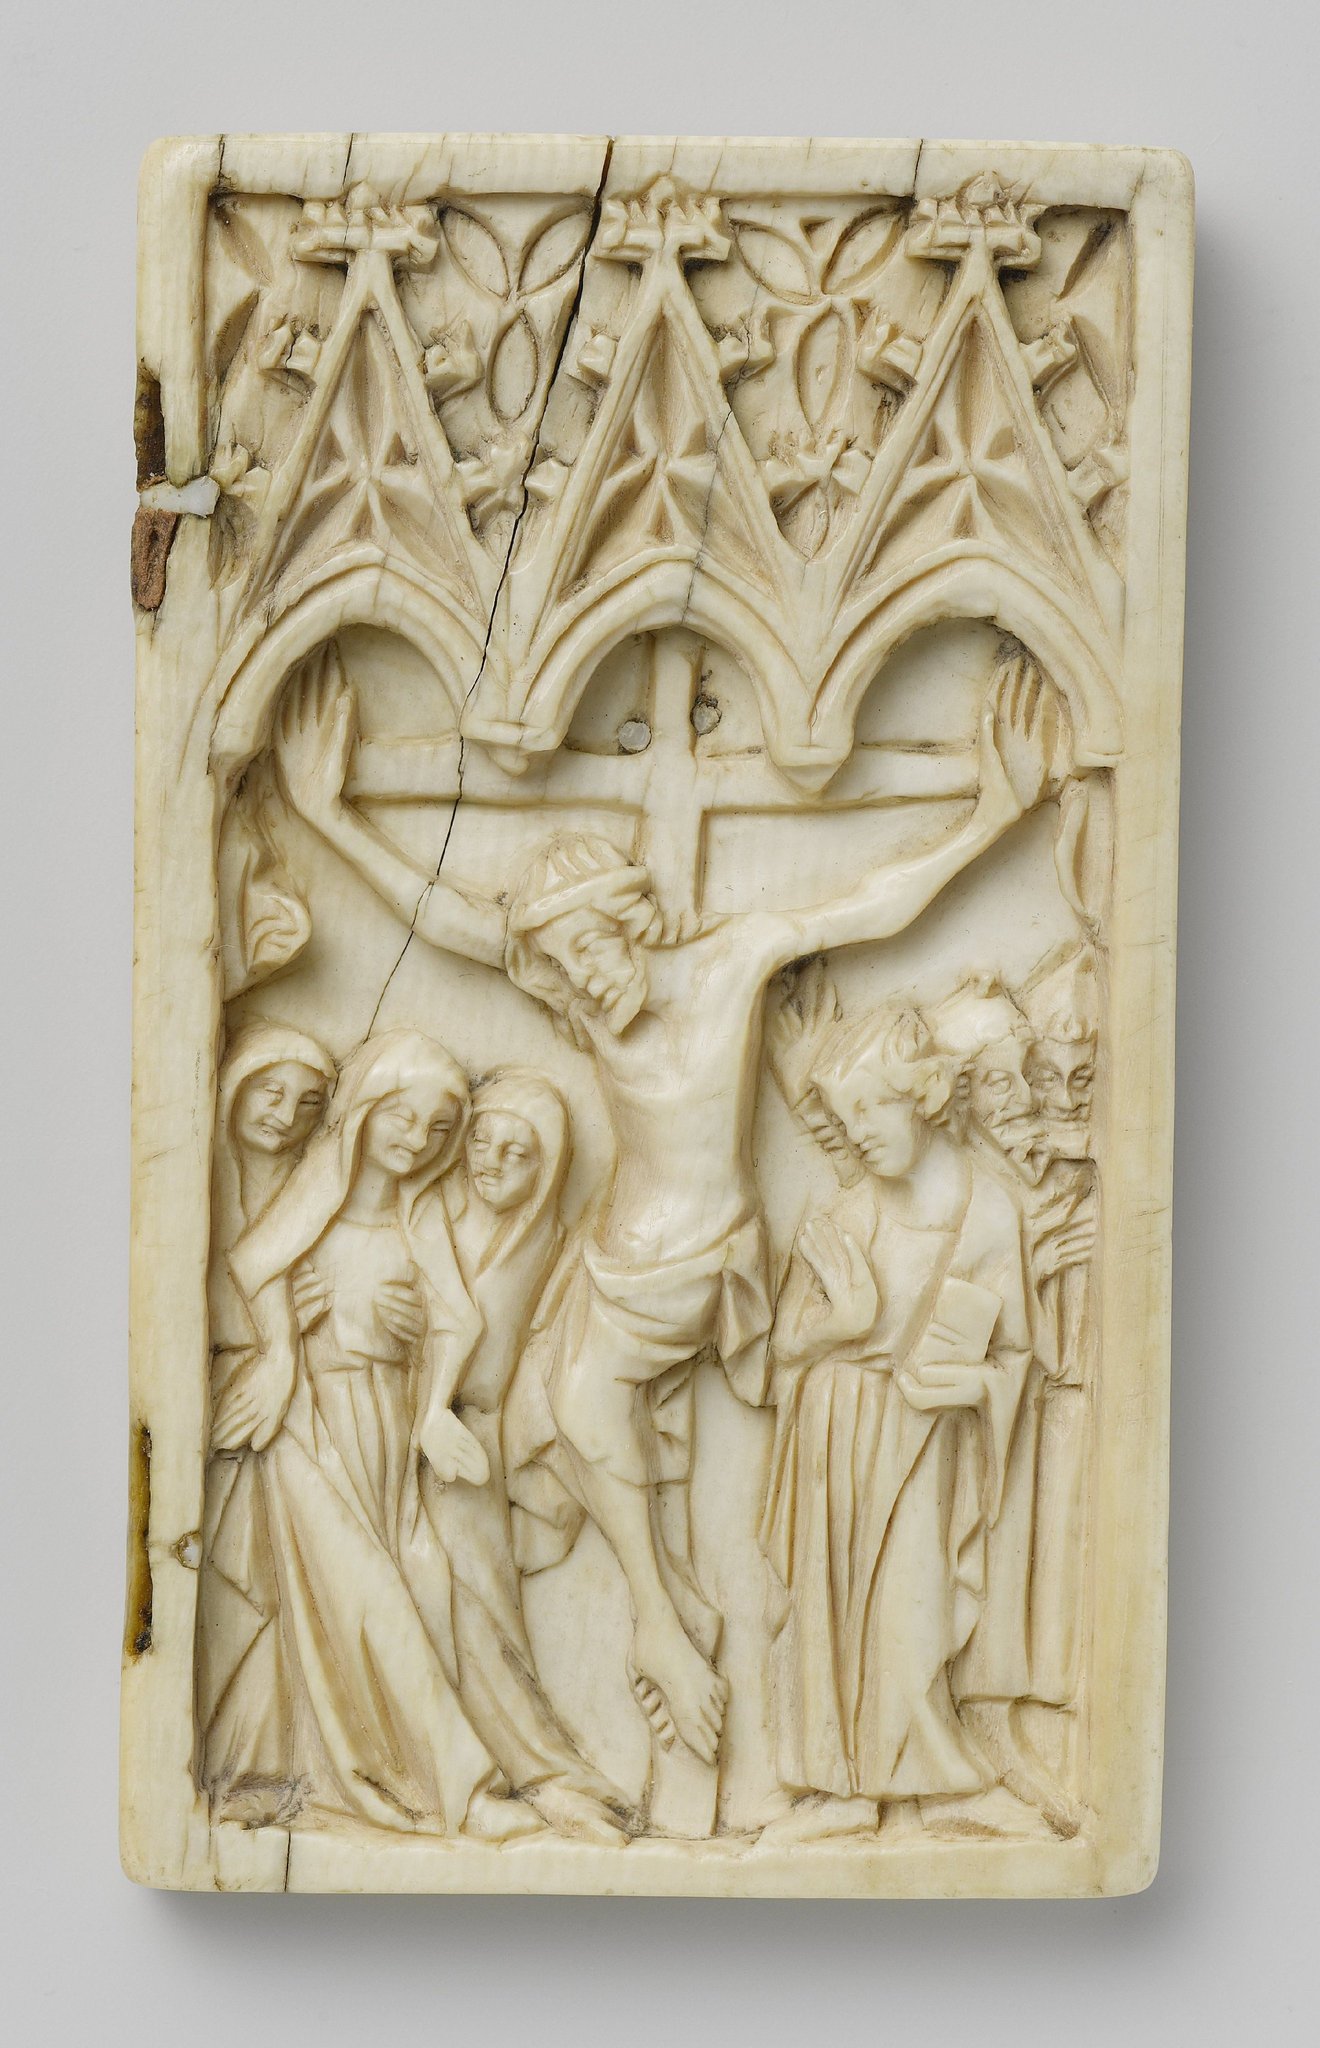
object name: diptych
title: Right wing of a diptych with the Crucifixion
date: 1375-1400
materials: ivory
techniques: cutting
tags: crucified christ with mary and john on either side of the cross; holy rood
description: Onder een drievoudige gotische arcatuur staat het kruis met Christus. Links de in zwijm vallende Maria onder de armen opgevangen door twee heilige vrouwen, rechts Johannes met een boek, gebarend met de rechterhand, en meer op de achtergrond twee farizeeërs van wie een naar Christus wijst. Aan beide zijden van Christus zon en maan.